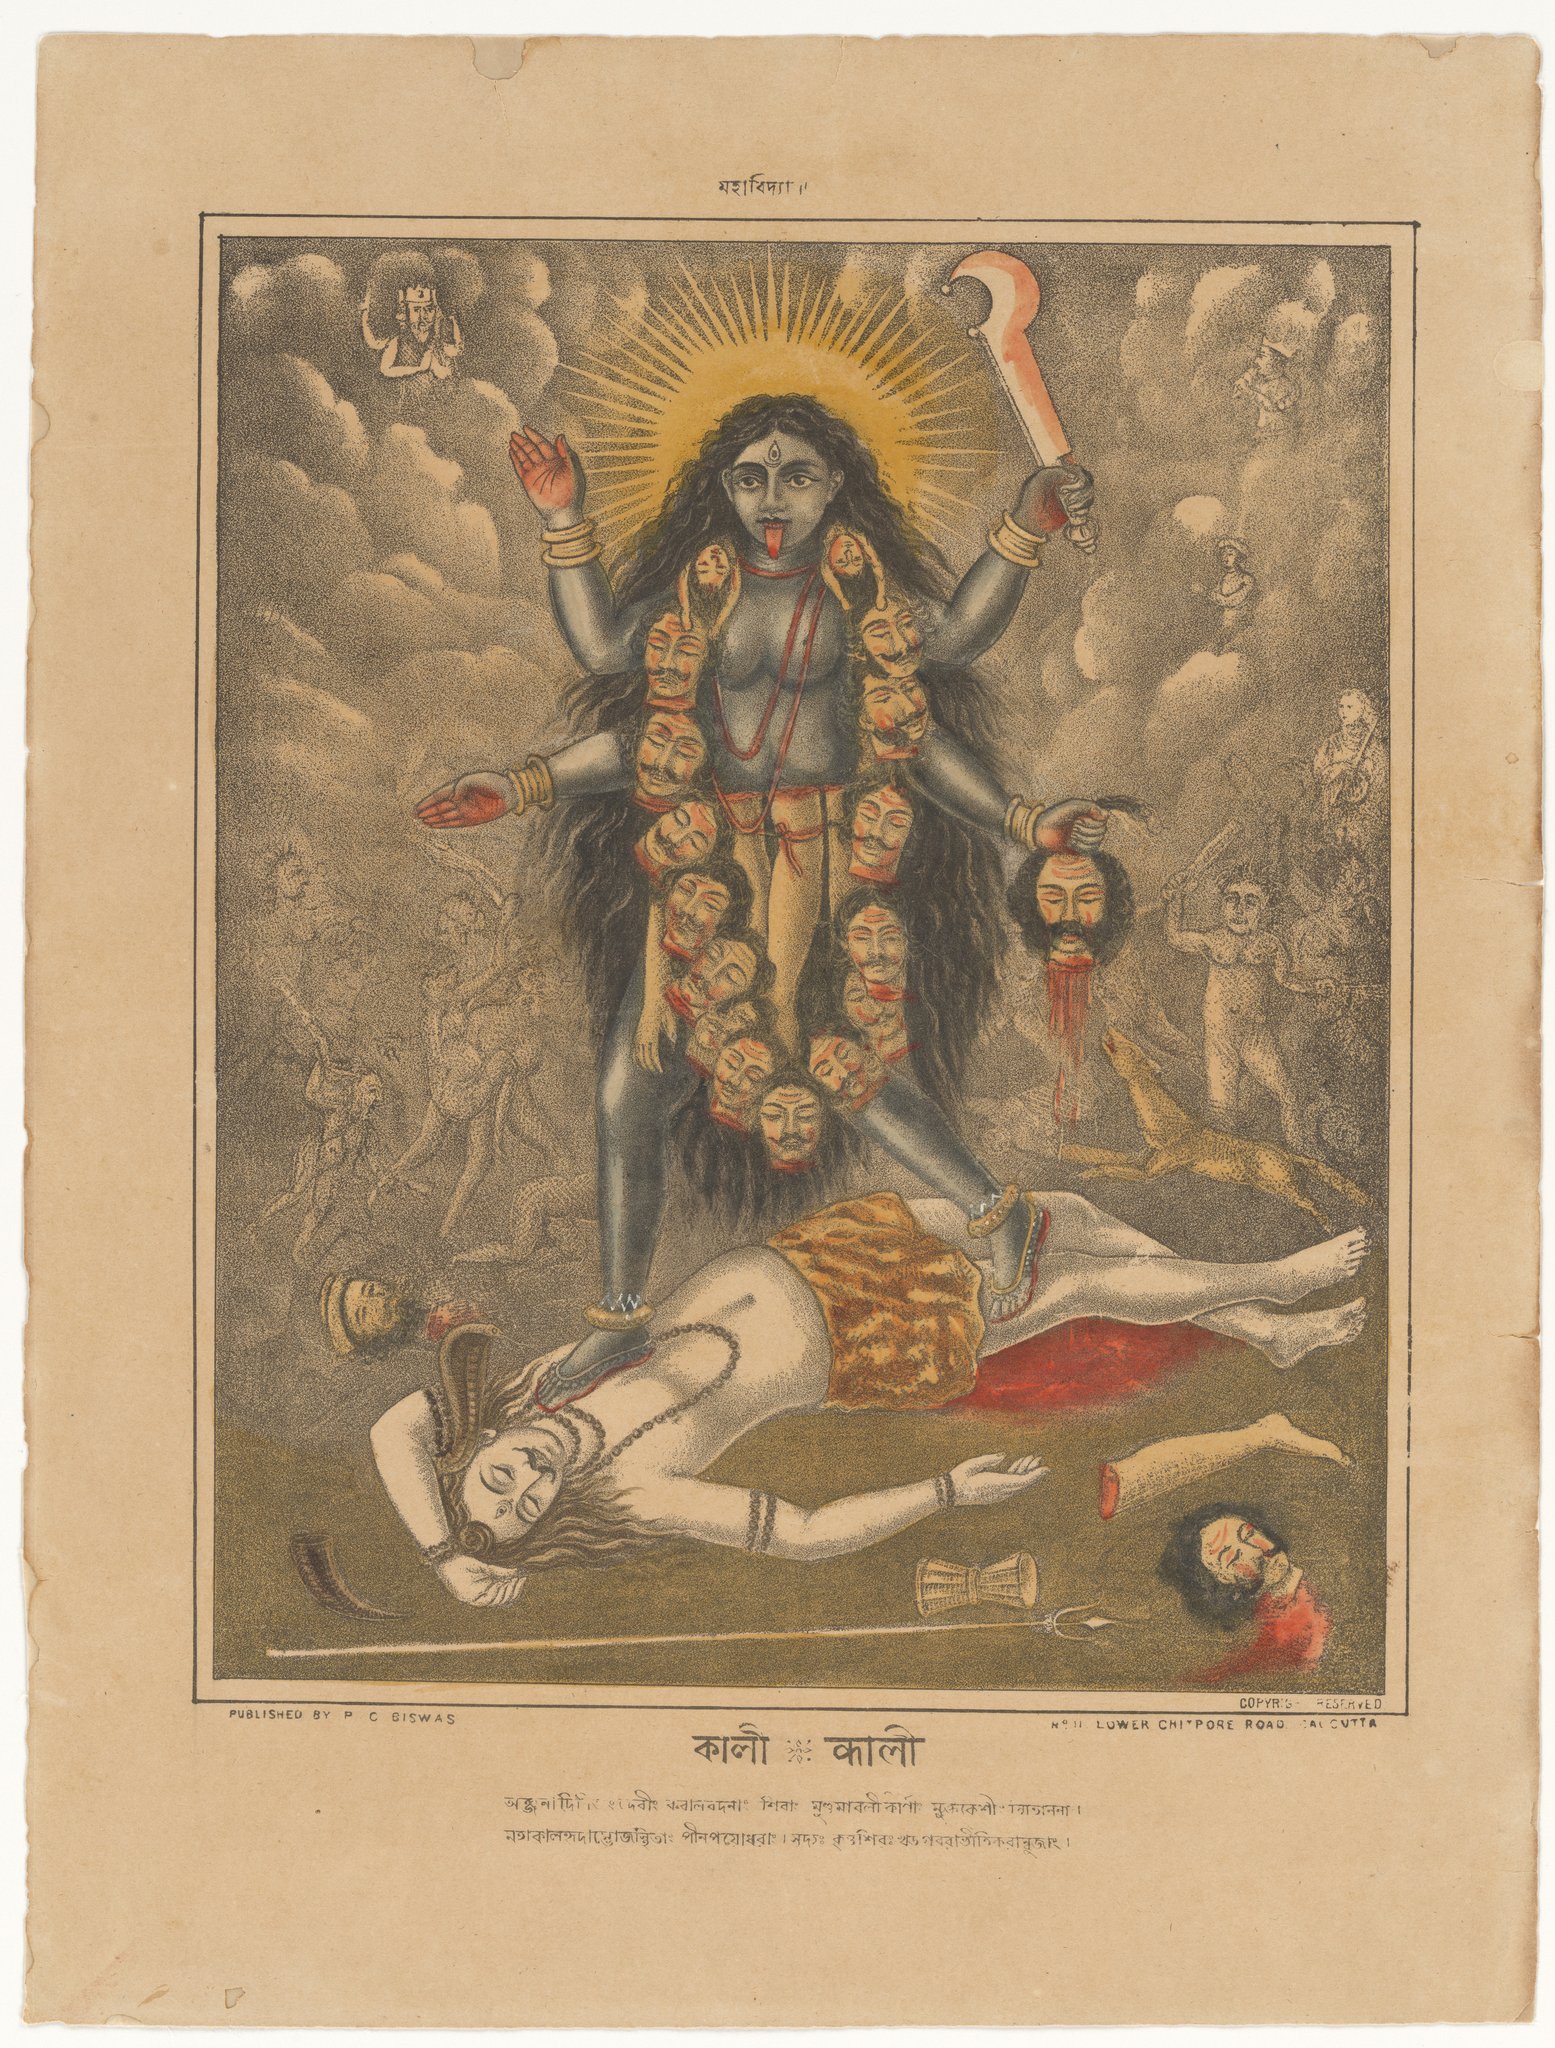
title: Goddess Kali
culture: west bengali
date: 1880-1885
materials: glaze, watercolor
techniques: hand coloring, lithograph, printing